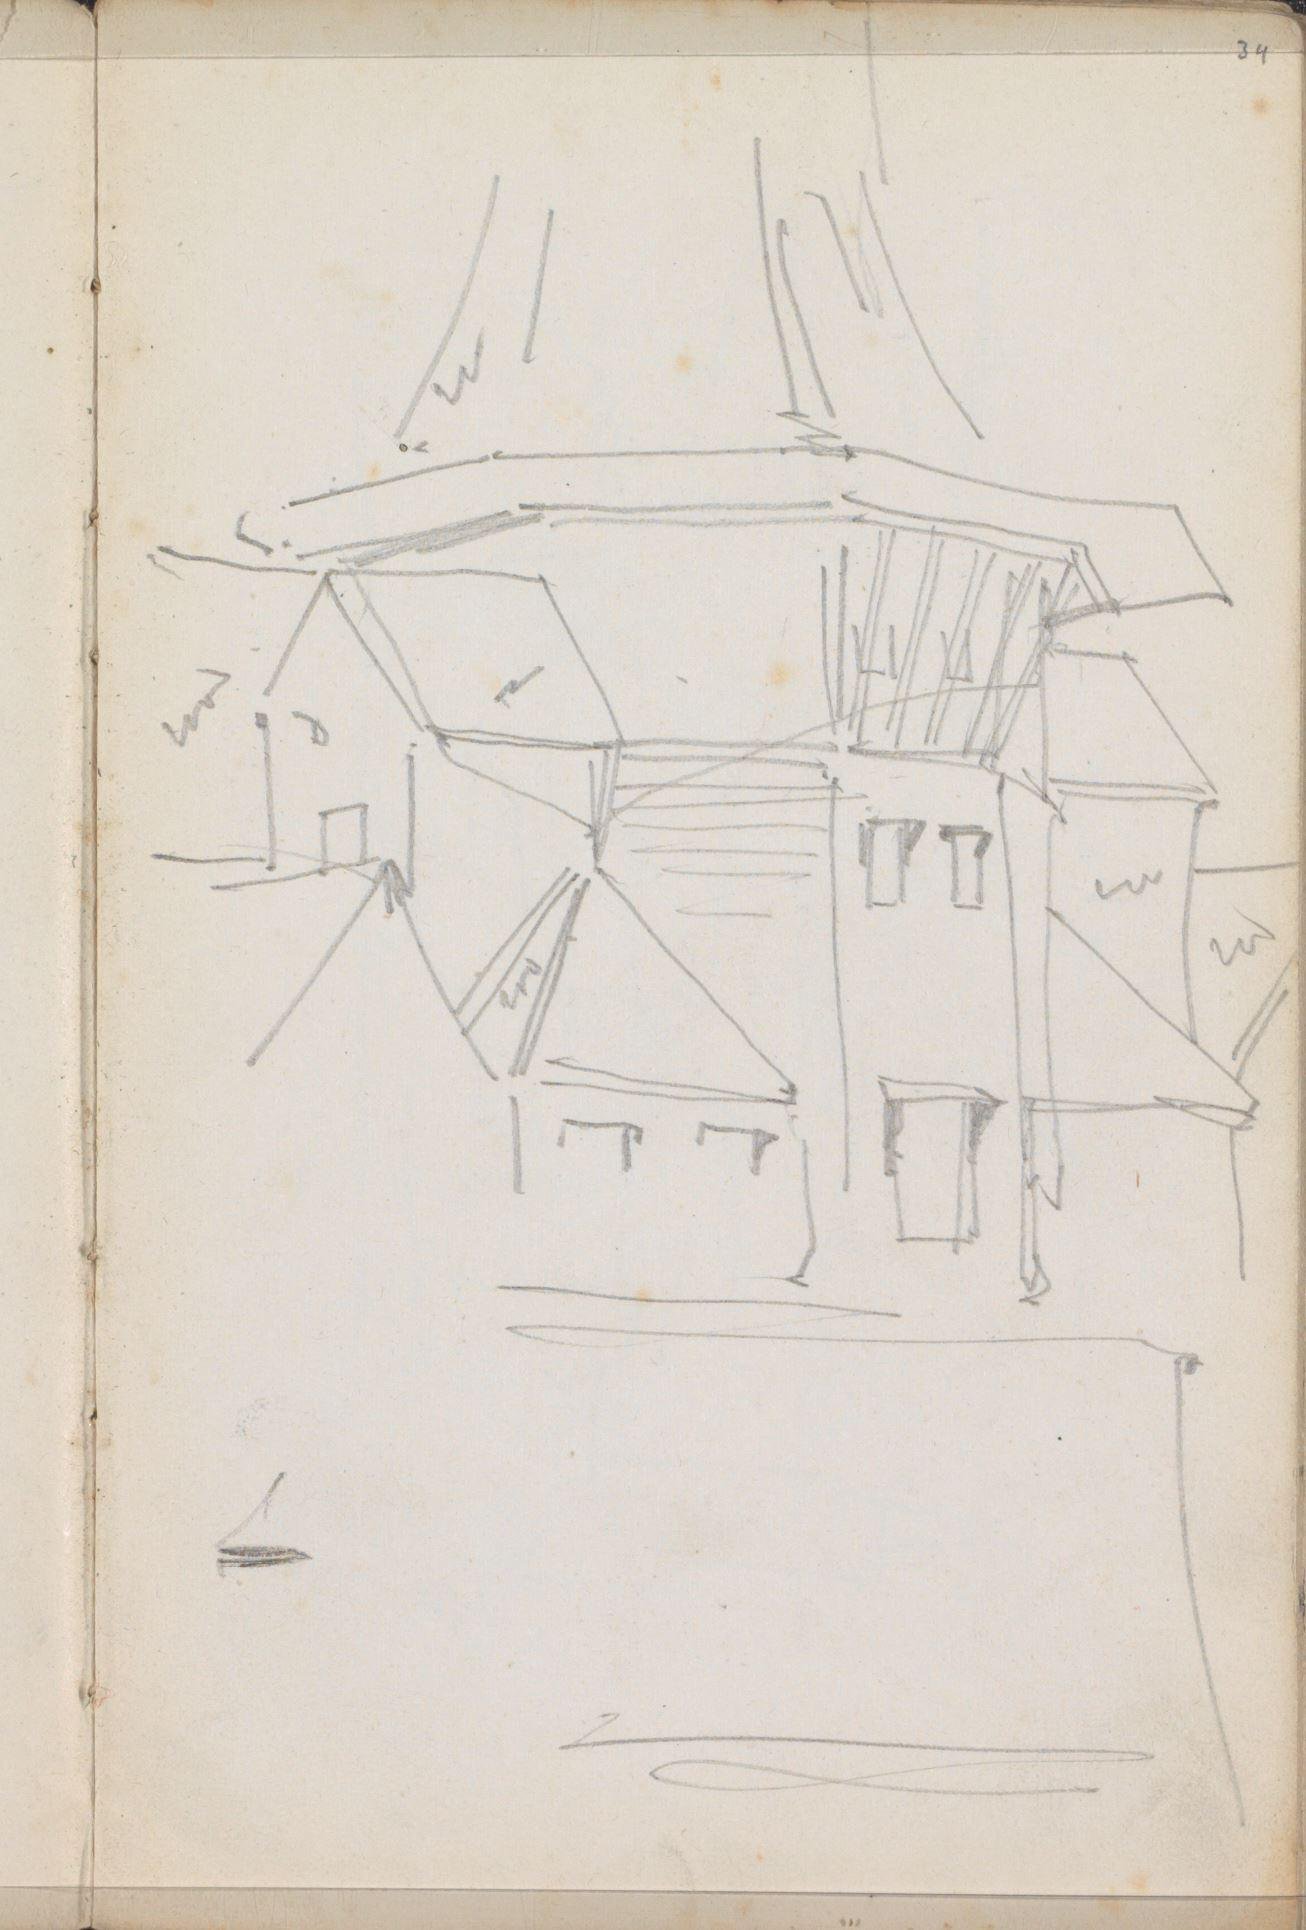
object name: sketchbook leaf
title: Gezicht op molen De Eendracht te Gorinchem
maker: george hendrik breitner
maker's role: draughtsman, painter, print maker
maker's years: 1857-1923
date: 1880-1882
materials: paper, pencil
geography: gorinchem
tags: windmill, civic architecture; edifices; dwellings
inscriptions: kleurnotitie, handgeschreven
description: Pagina 34 uit een schetsboek met 72 bladen.